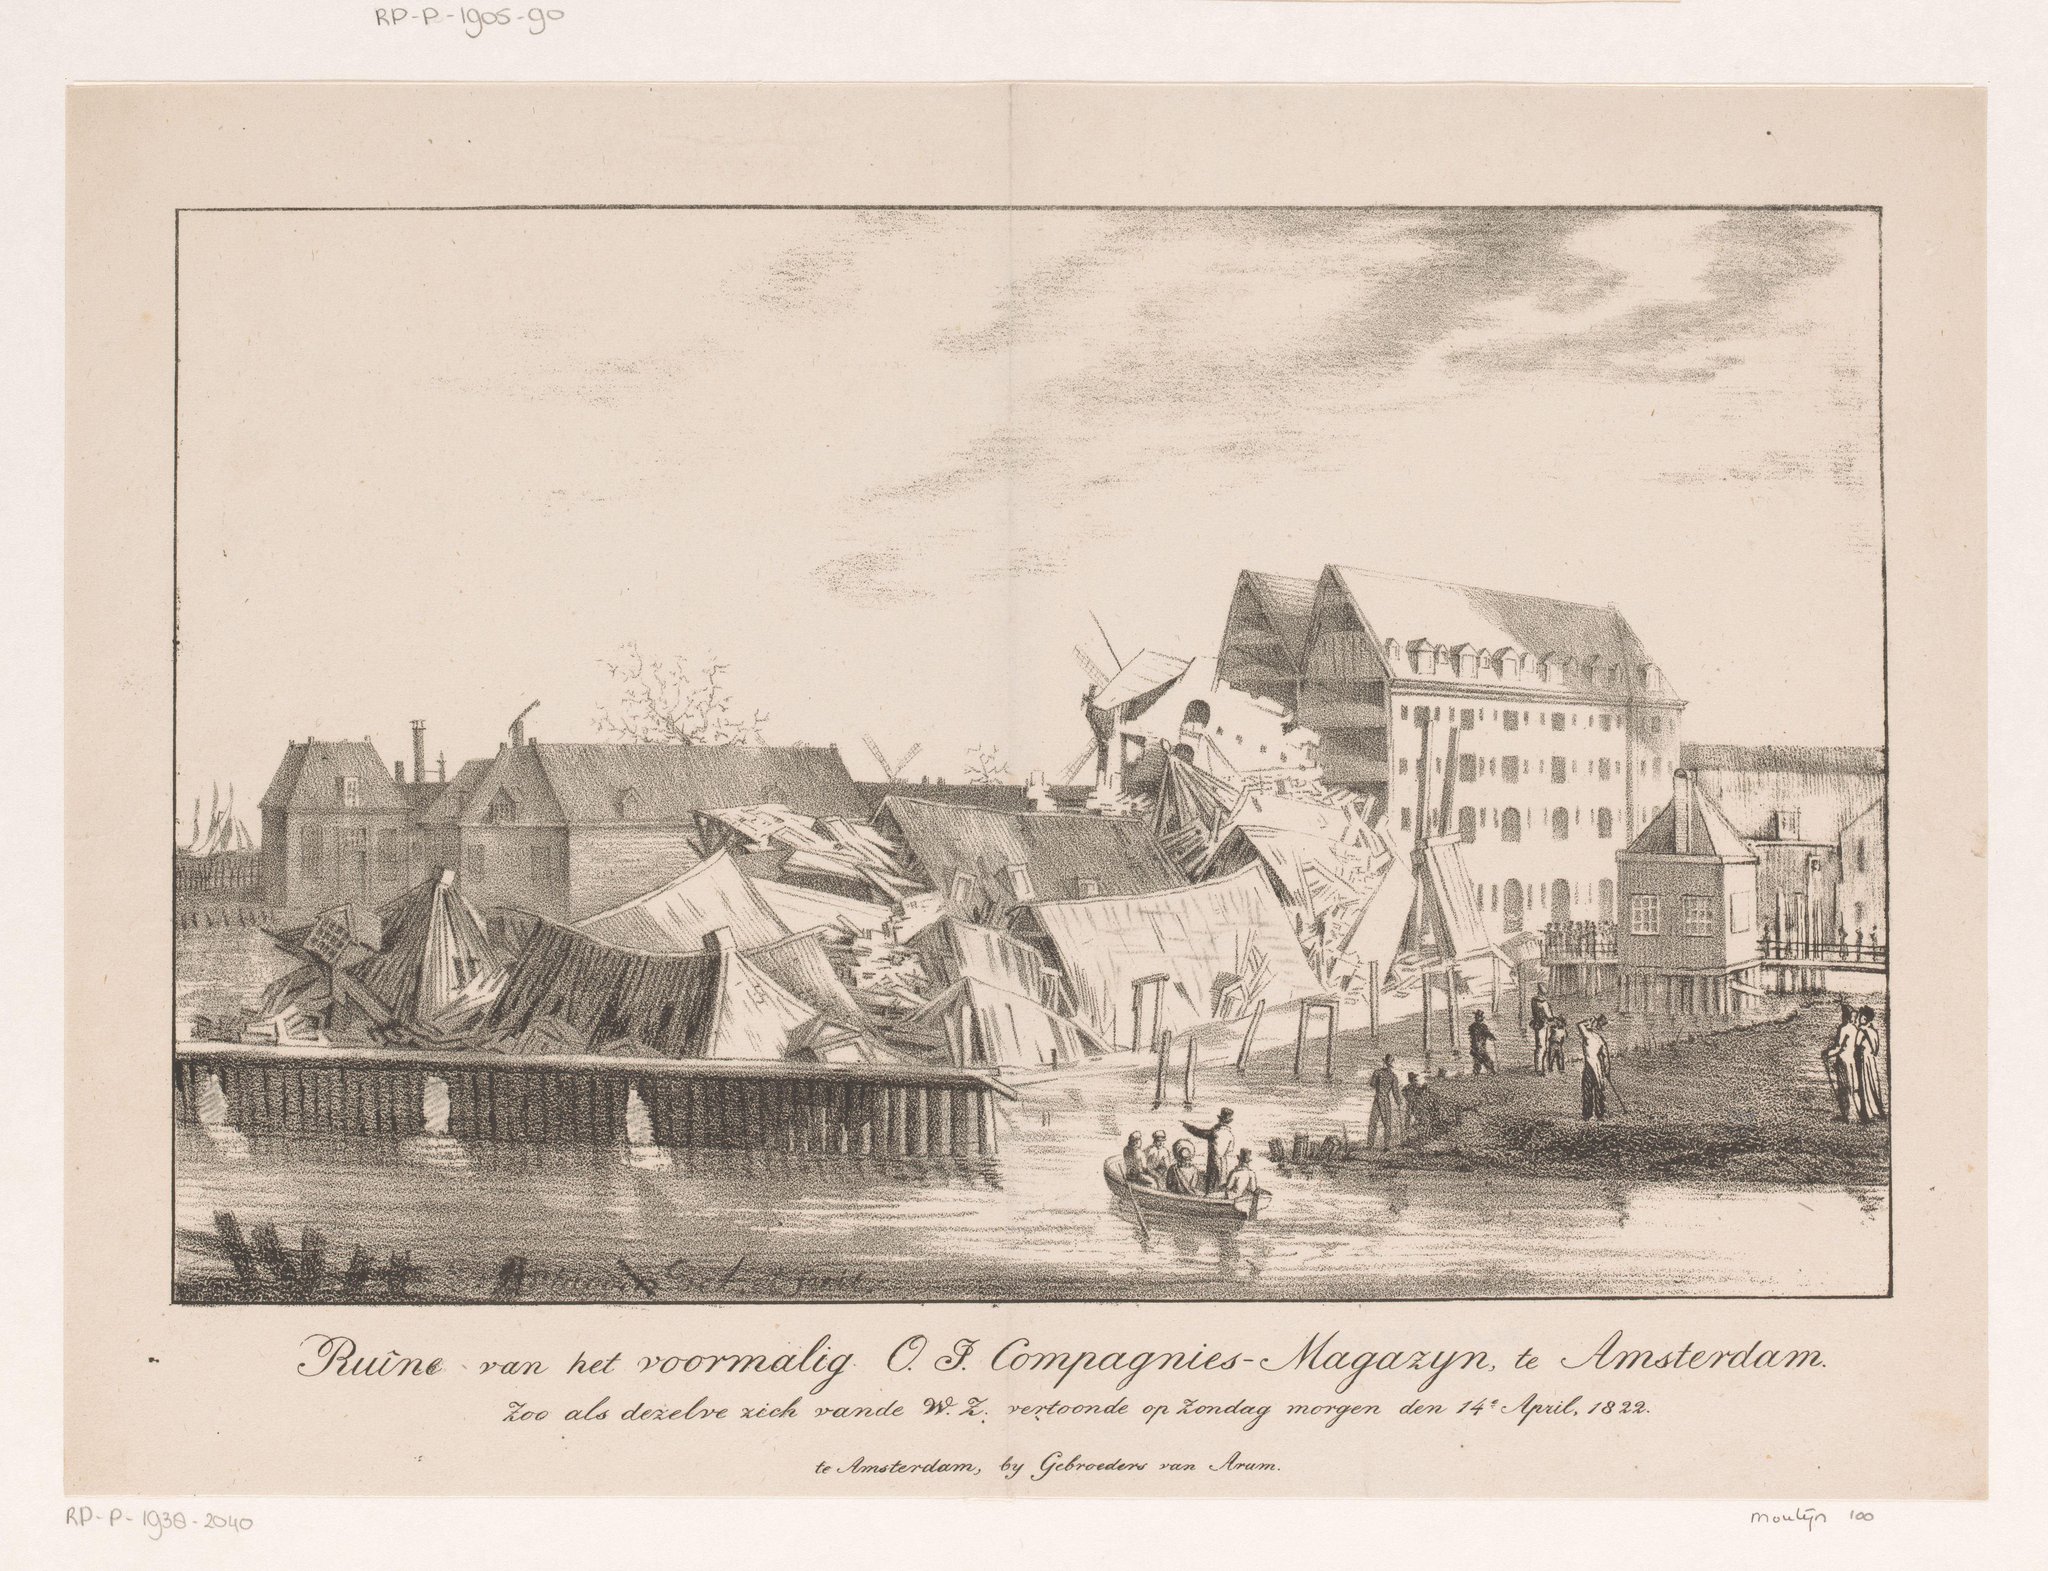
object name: print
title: Ruîne van het voormalig O.I. Compagnies-Magazijn, te Amsterdam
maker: jacob plügger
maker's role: print maker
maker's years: 1795-1871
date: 1822-1837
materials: paper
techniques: lithograph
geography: amsterdam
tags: ruin of a building ~ architecture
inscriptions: collector's mark: Lugt 2228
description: Ruïne van het Oost-Indisch Zeemagazijn te Amsterdam, na de instorting op 13-14 april 1822. Rechts figuren in een roeiboot en op de kade.